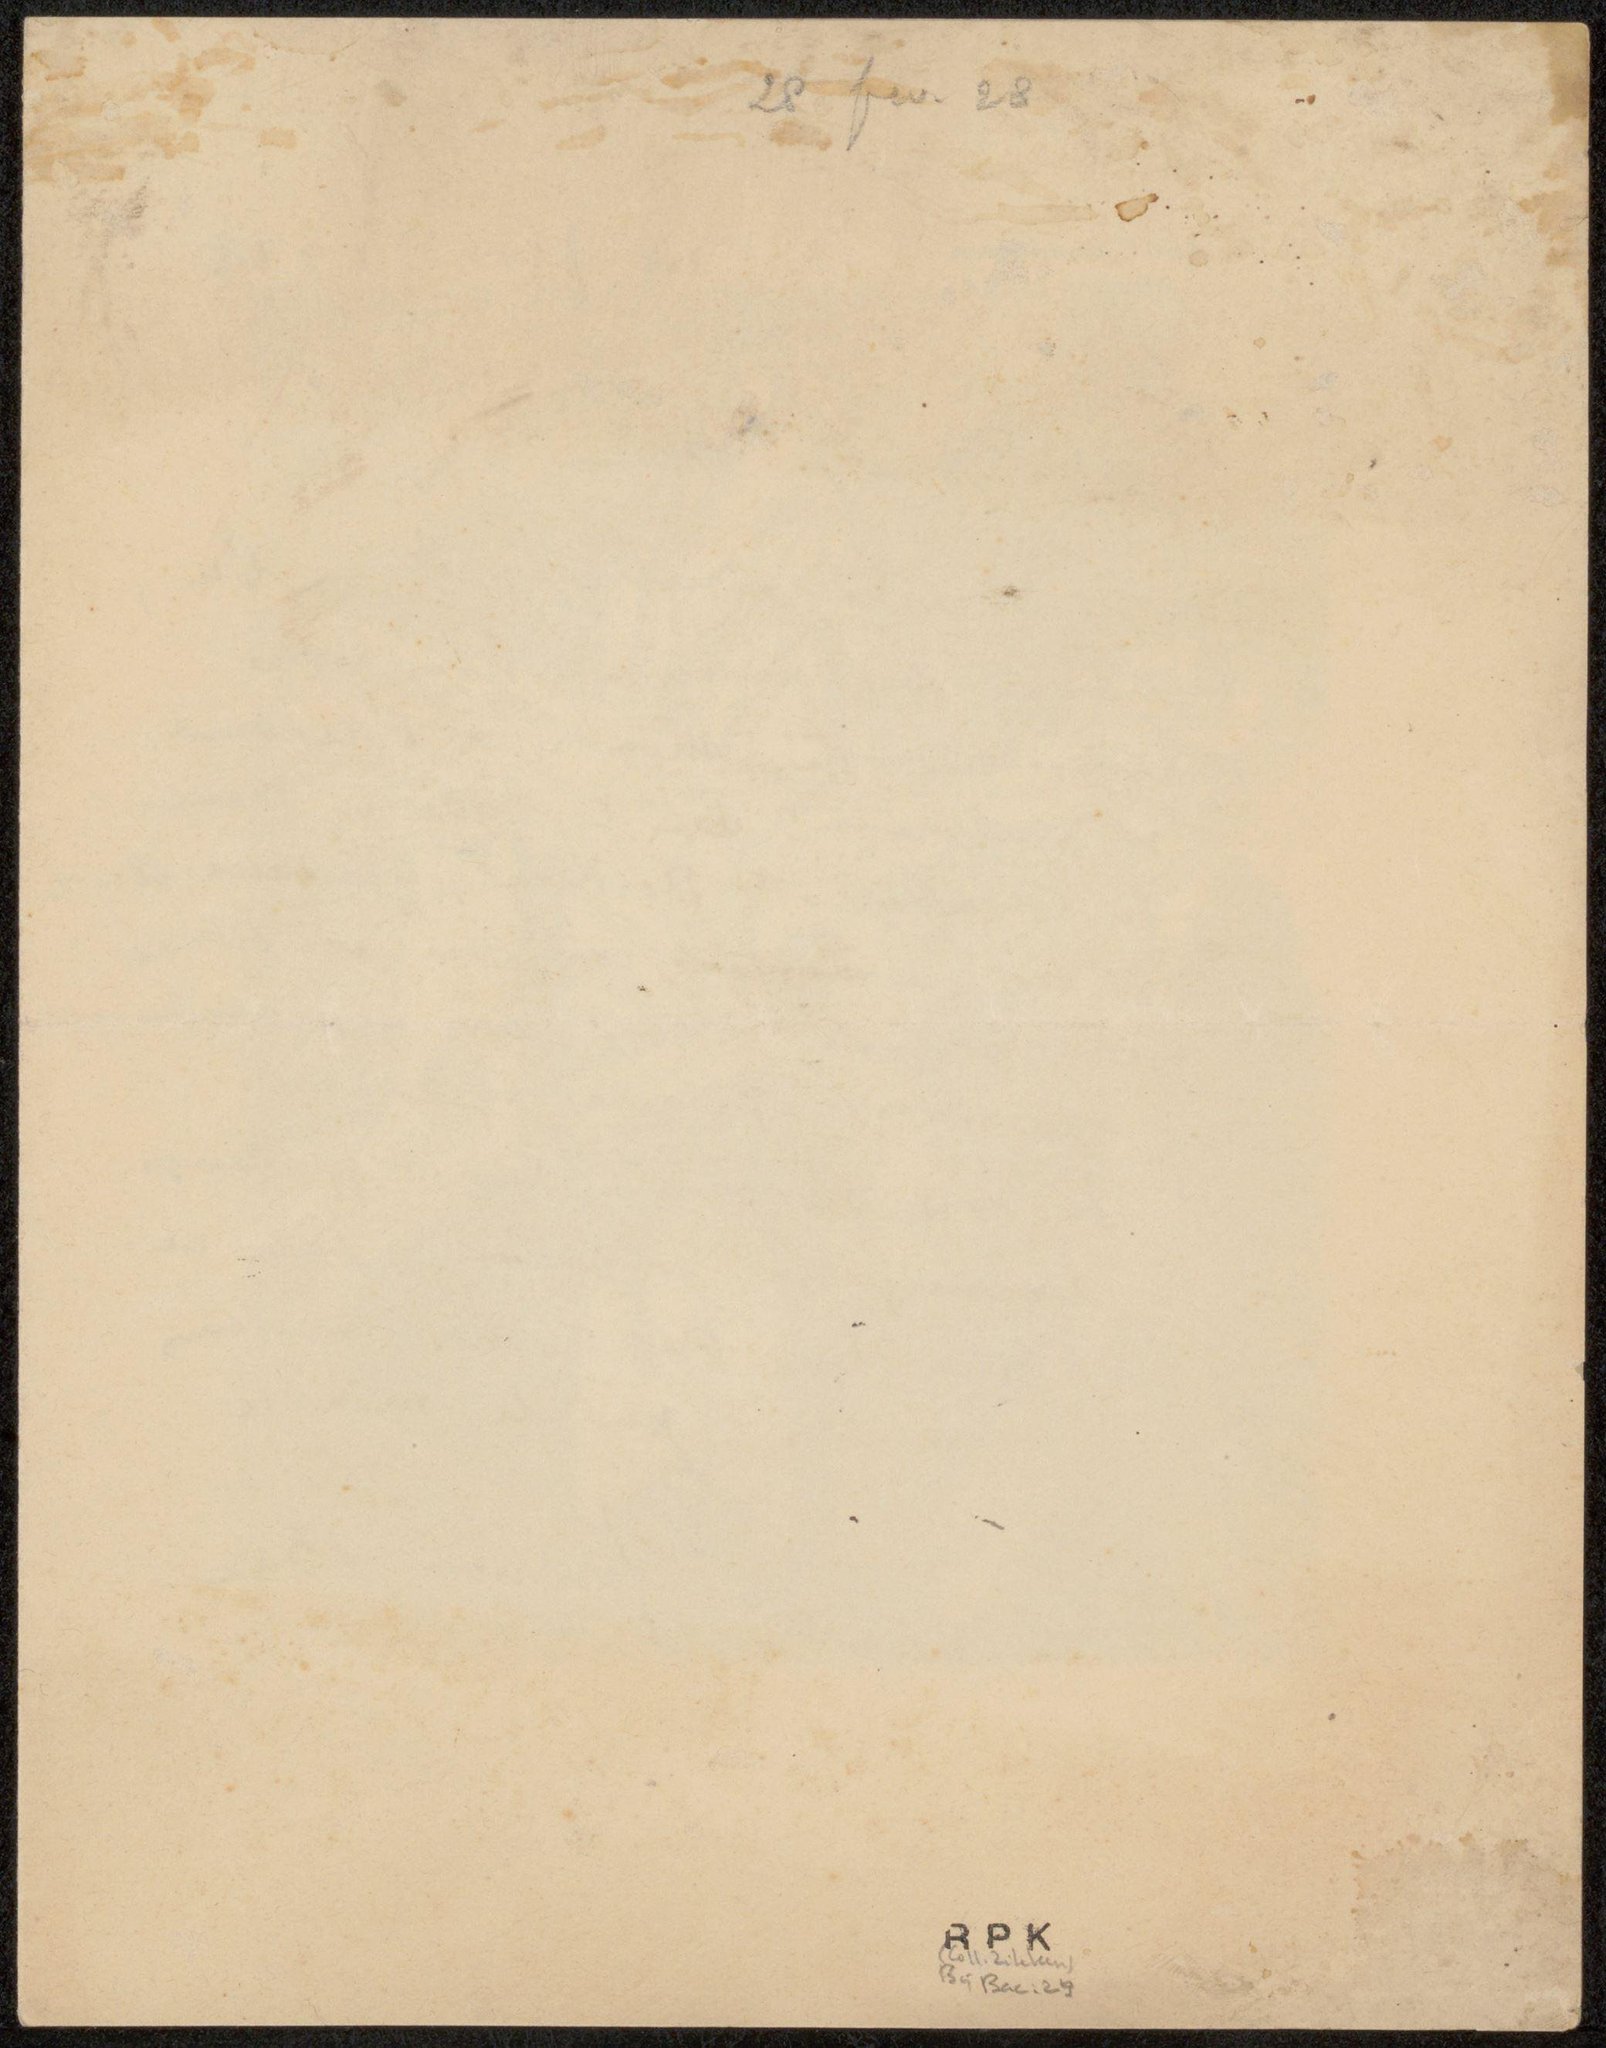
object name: letter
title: Brief aan Philip Zilcken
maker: ferdinand-sigismund bac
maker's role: draughtsman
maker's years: 1859-1952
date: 1928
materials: ink, paper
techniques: pen, printing, writing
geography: menton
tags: painter, draughtsman, philip zilcken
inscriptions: collector's mark: ‘RPK’